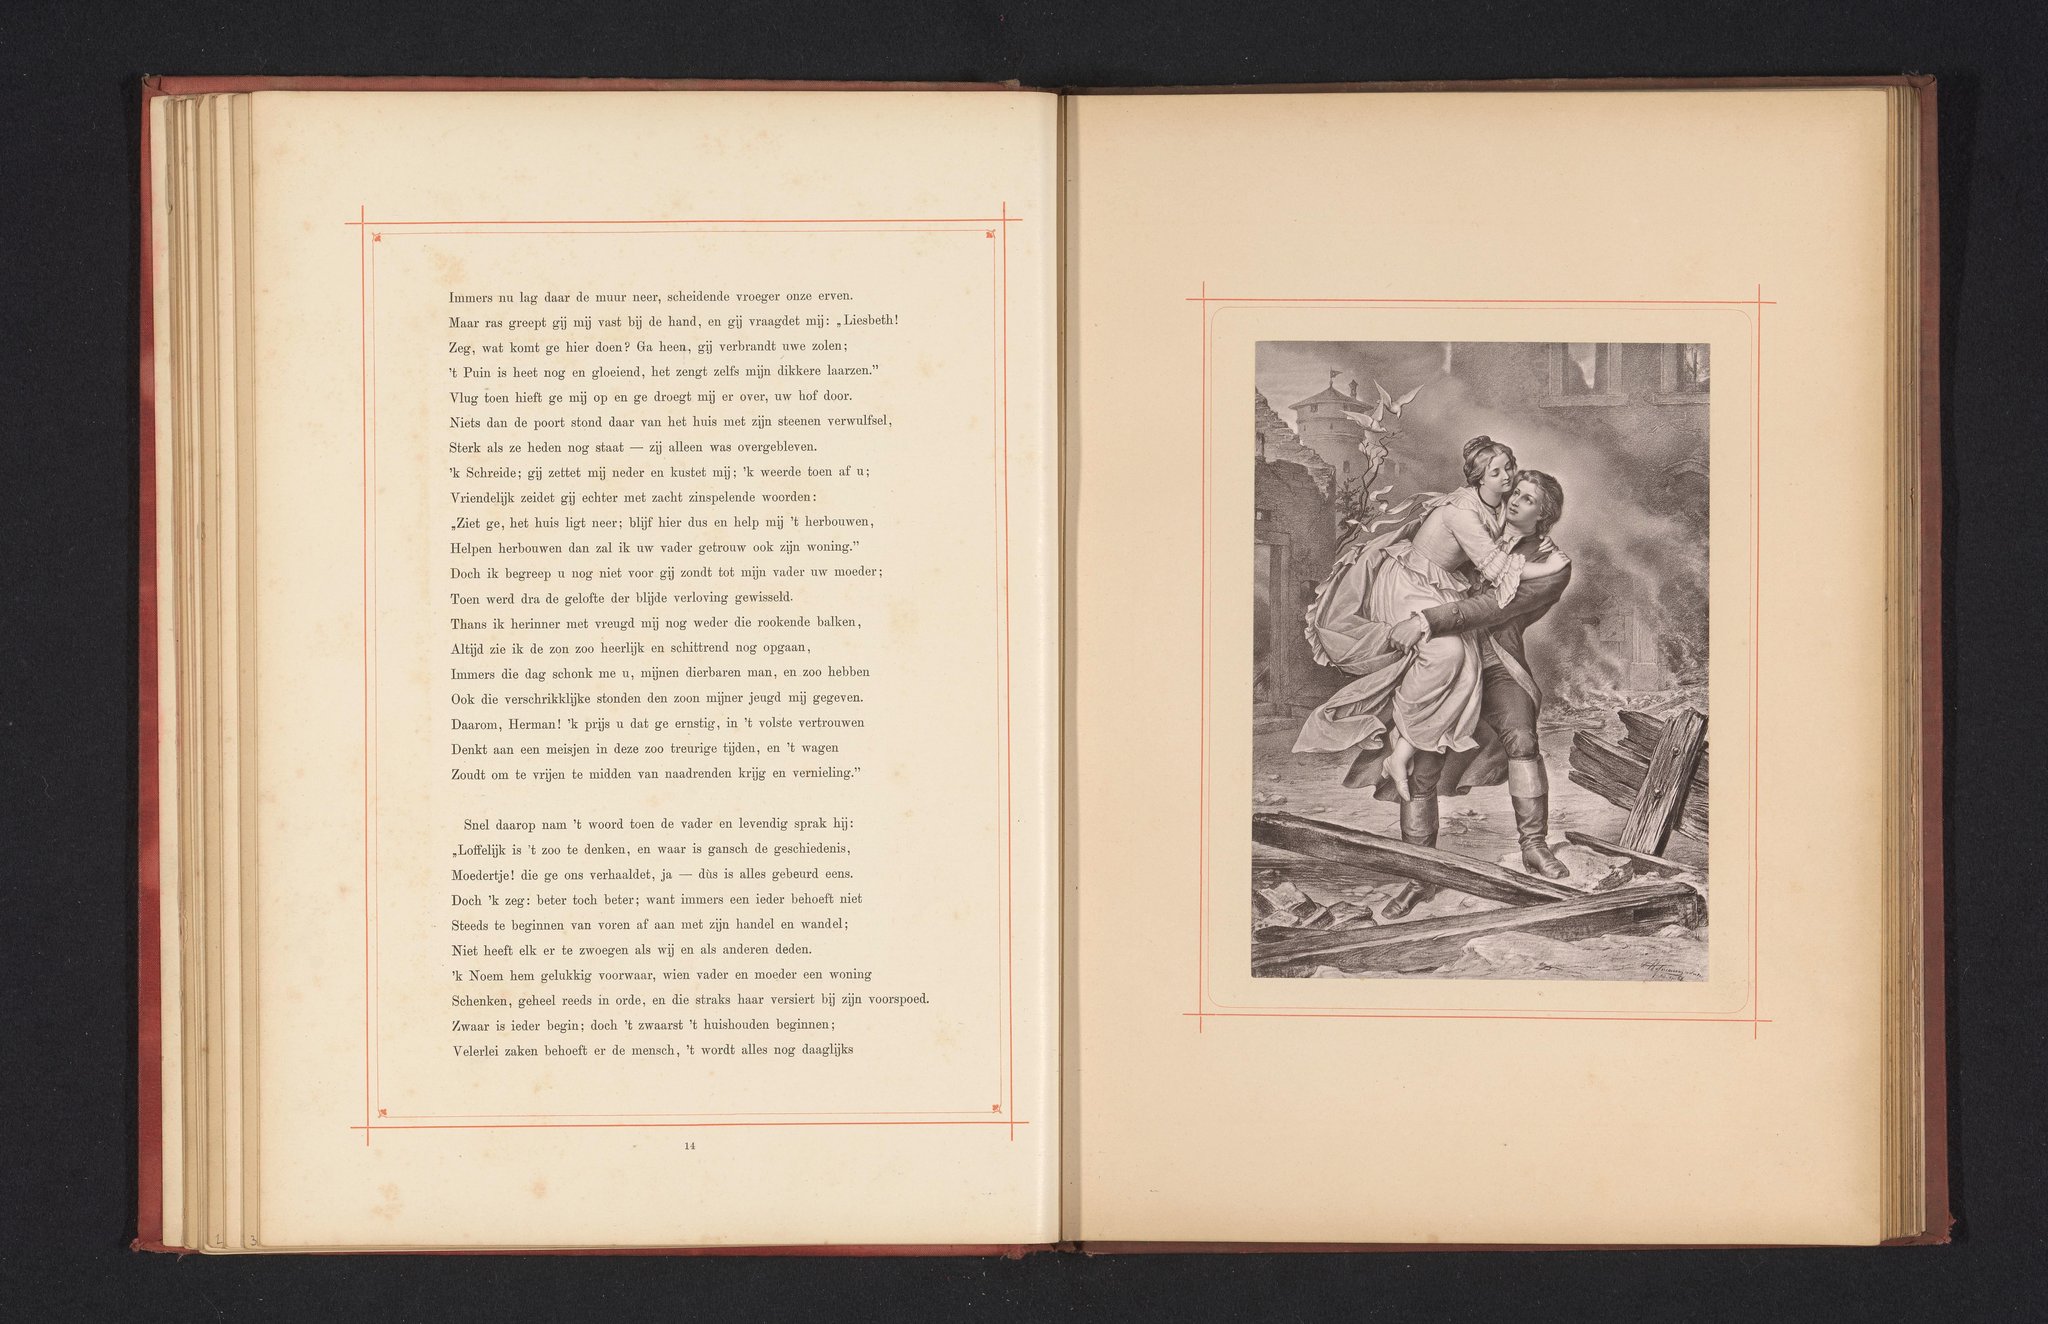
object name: reproduction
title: Fotoreproductie van een tekening, voorstellende Hermann draagt Dorothea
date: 1875-1885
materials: paper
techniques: photograph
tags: adult woman, carrying a person, adult man